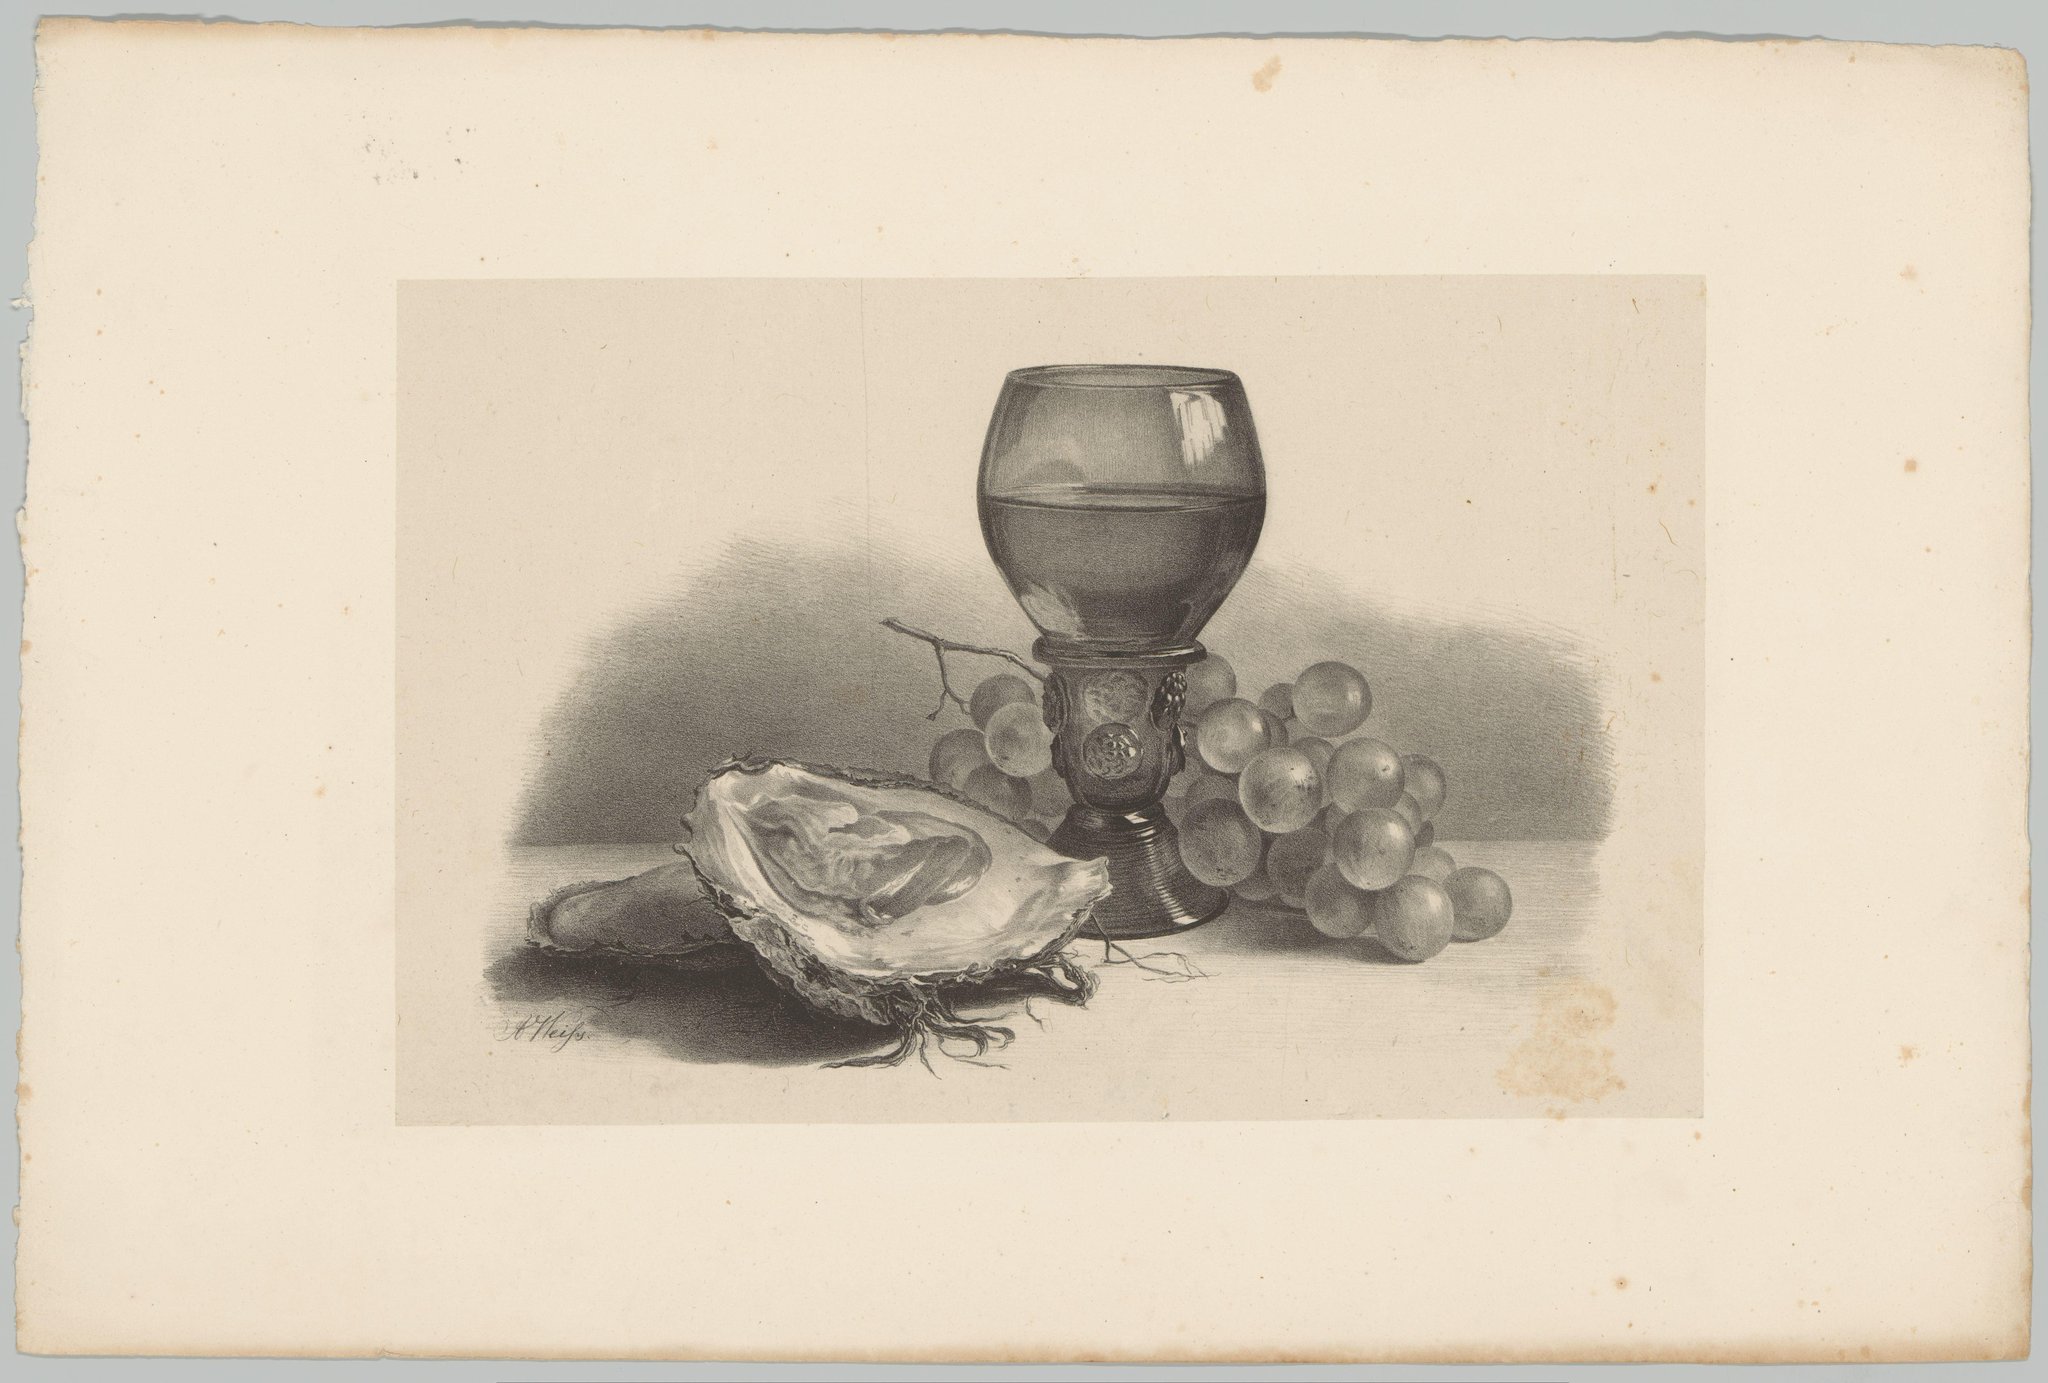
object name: print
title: Stilleven met glas, oesters en druiven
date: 1820-1833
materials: paper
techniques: lithograph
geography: amsterdam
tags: molluscs: oyster, fruits, foodstuffs; still life of foodstuffs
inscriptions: collector's mark: Lugt 2228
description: Onderdeel van een omslag met in totaal zevenenzeventig lithografieën van bloemen en fruit.